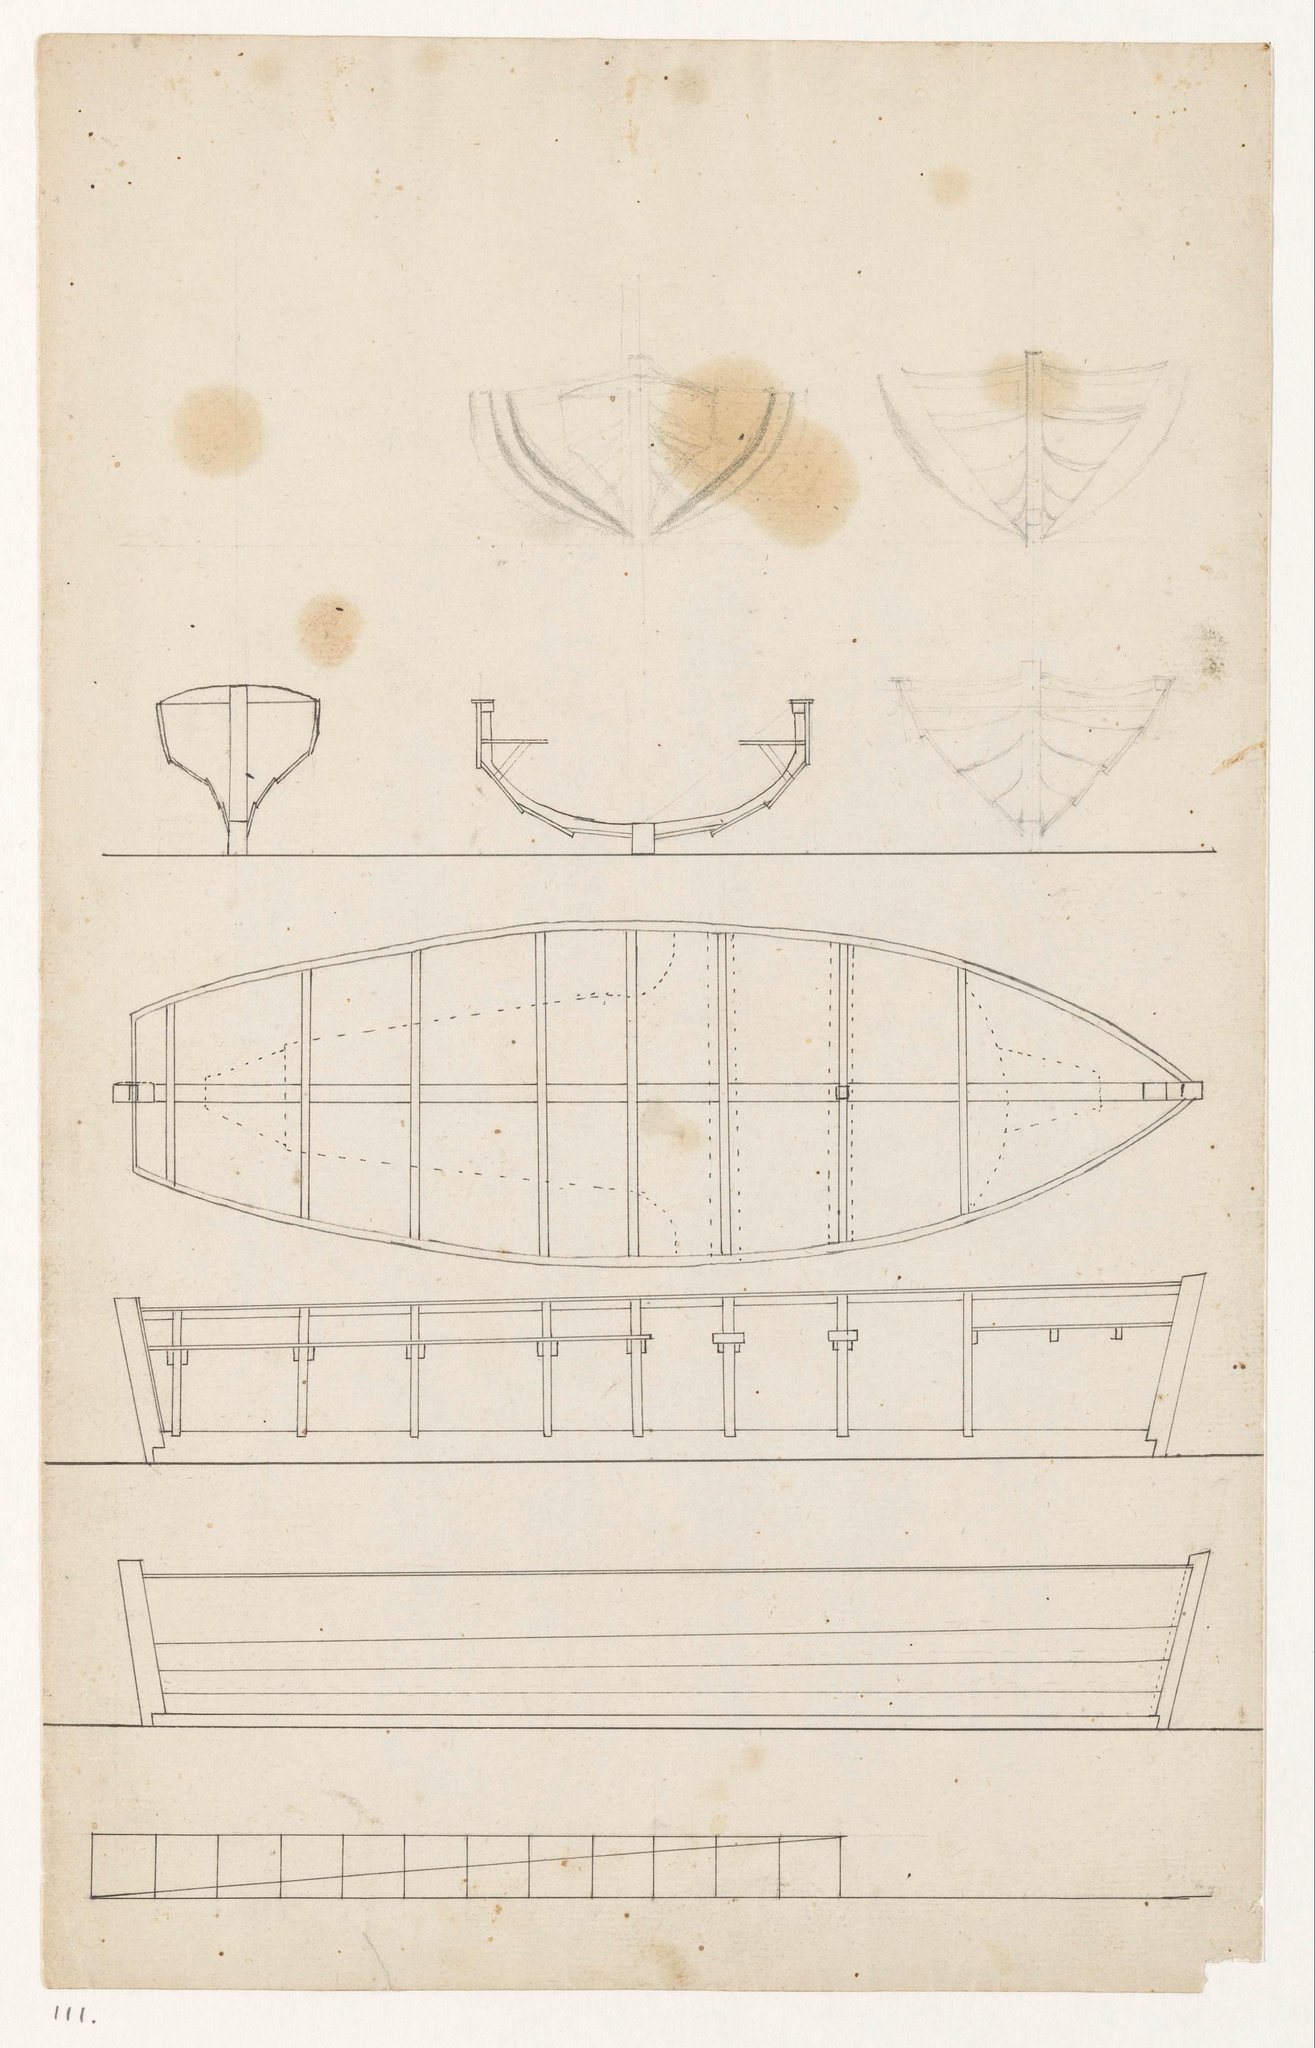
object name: drawing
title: Bouwtekening van een vlet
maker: jan brandes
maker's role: draughtsman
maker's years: 1743-1808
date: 1787-1808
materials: ink, paper, pencil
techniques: pen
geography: skälsebo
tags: rowing-boat, canoe, etc.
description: Bouwtekening van een vlet. Enkele doorsnedes, verhoudingen van kleine boot.